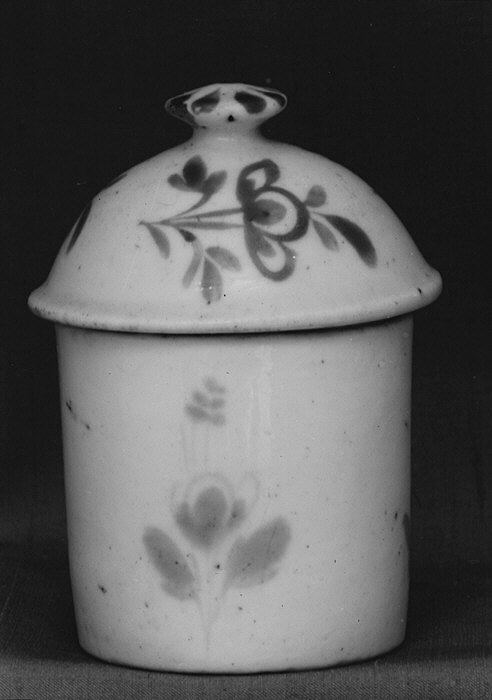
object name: toilet jar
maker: sceaux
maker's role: factory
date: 1775-1780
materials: soft paste porcelain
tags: flowers